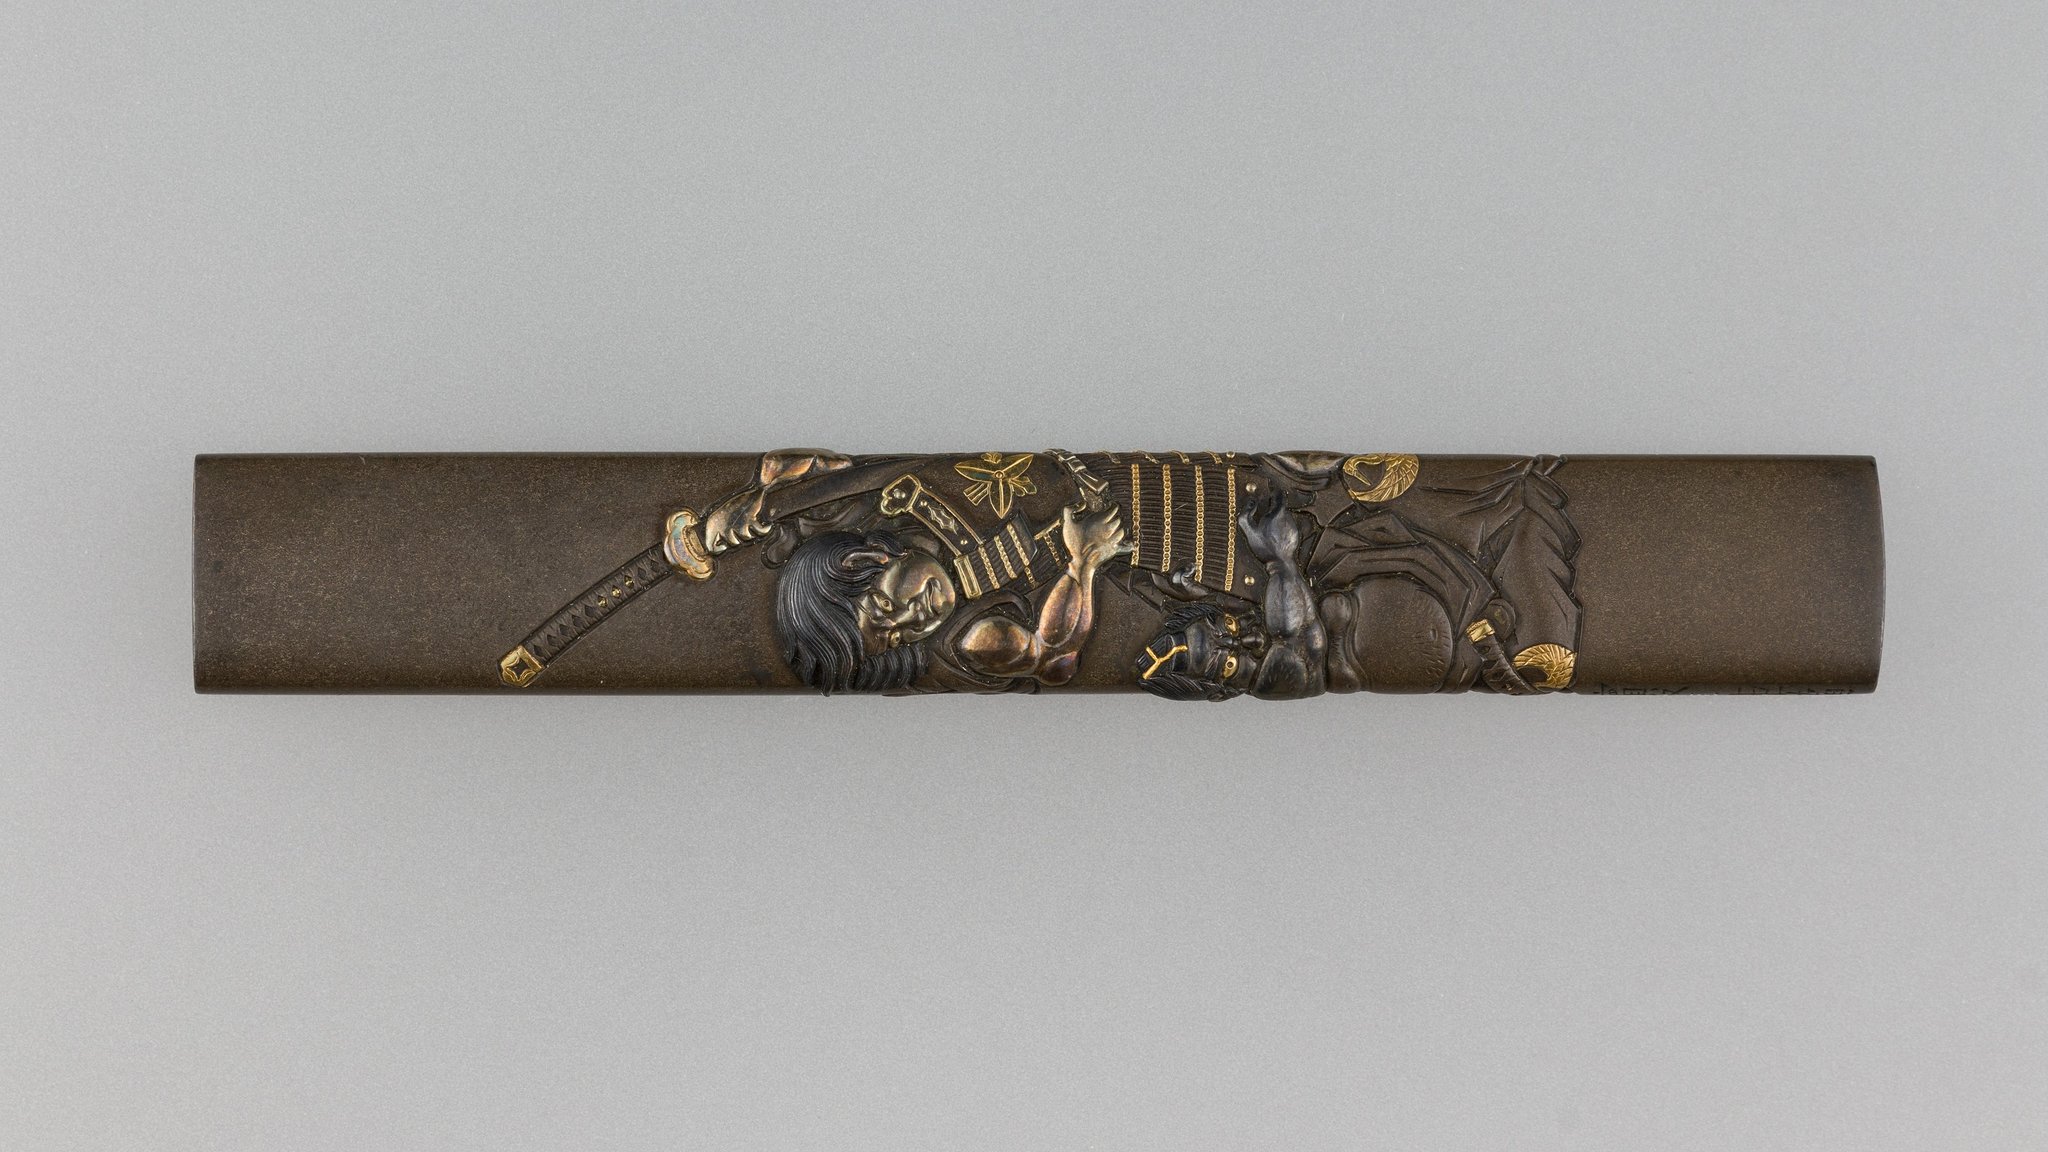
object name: knife handle kozuka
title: Knife Handle (Kozuka)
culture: japanese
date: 1770-1852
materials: gold alloy, silver alloy, gold, silver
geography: japan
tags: men